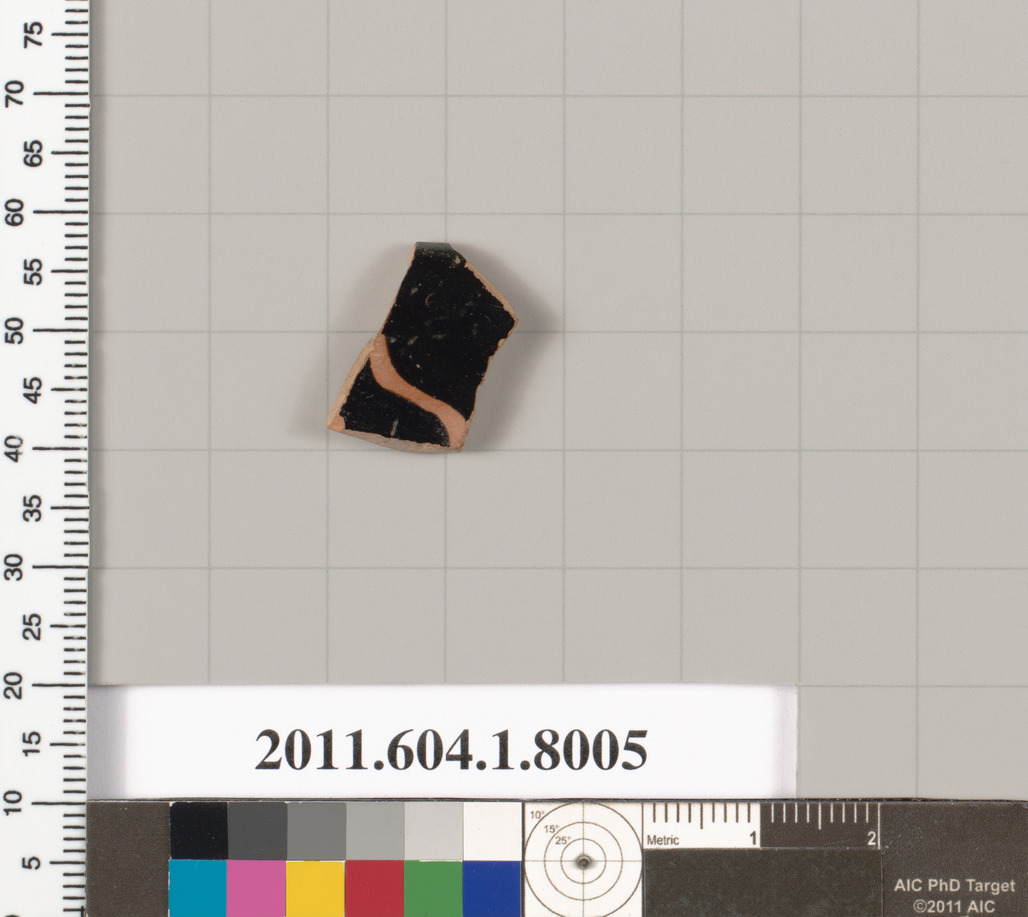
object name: kylix fragment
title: Terracotta rim fragment of a kylix (drinking cup)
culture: greek, attic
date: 460-450 BCE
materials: terracotta